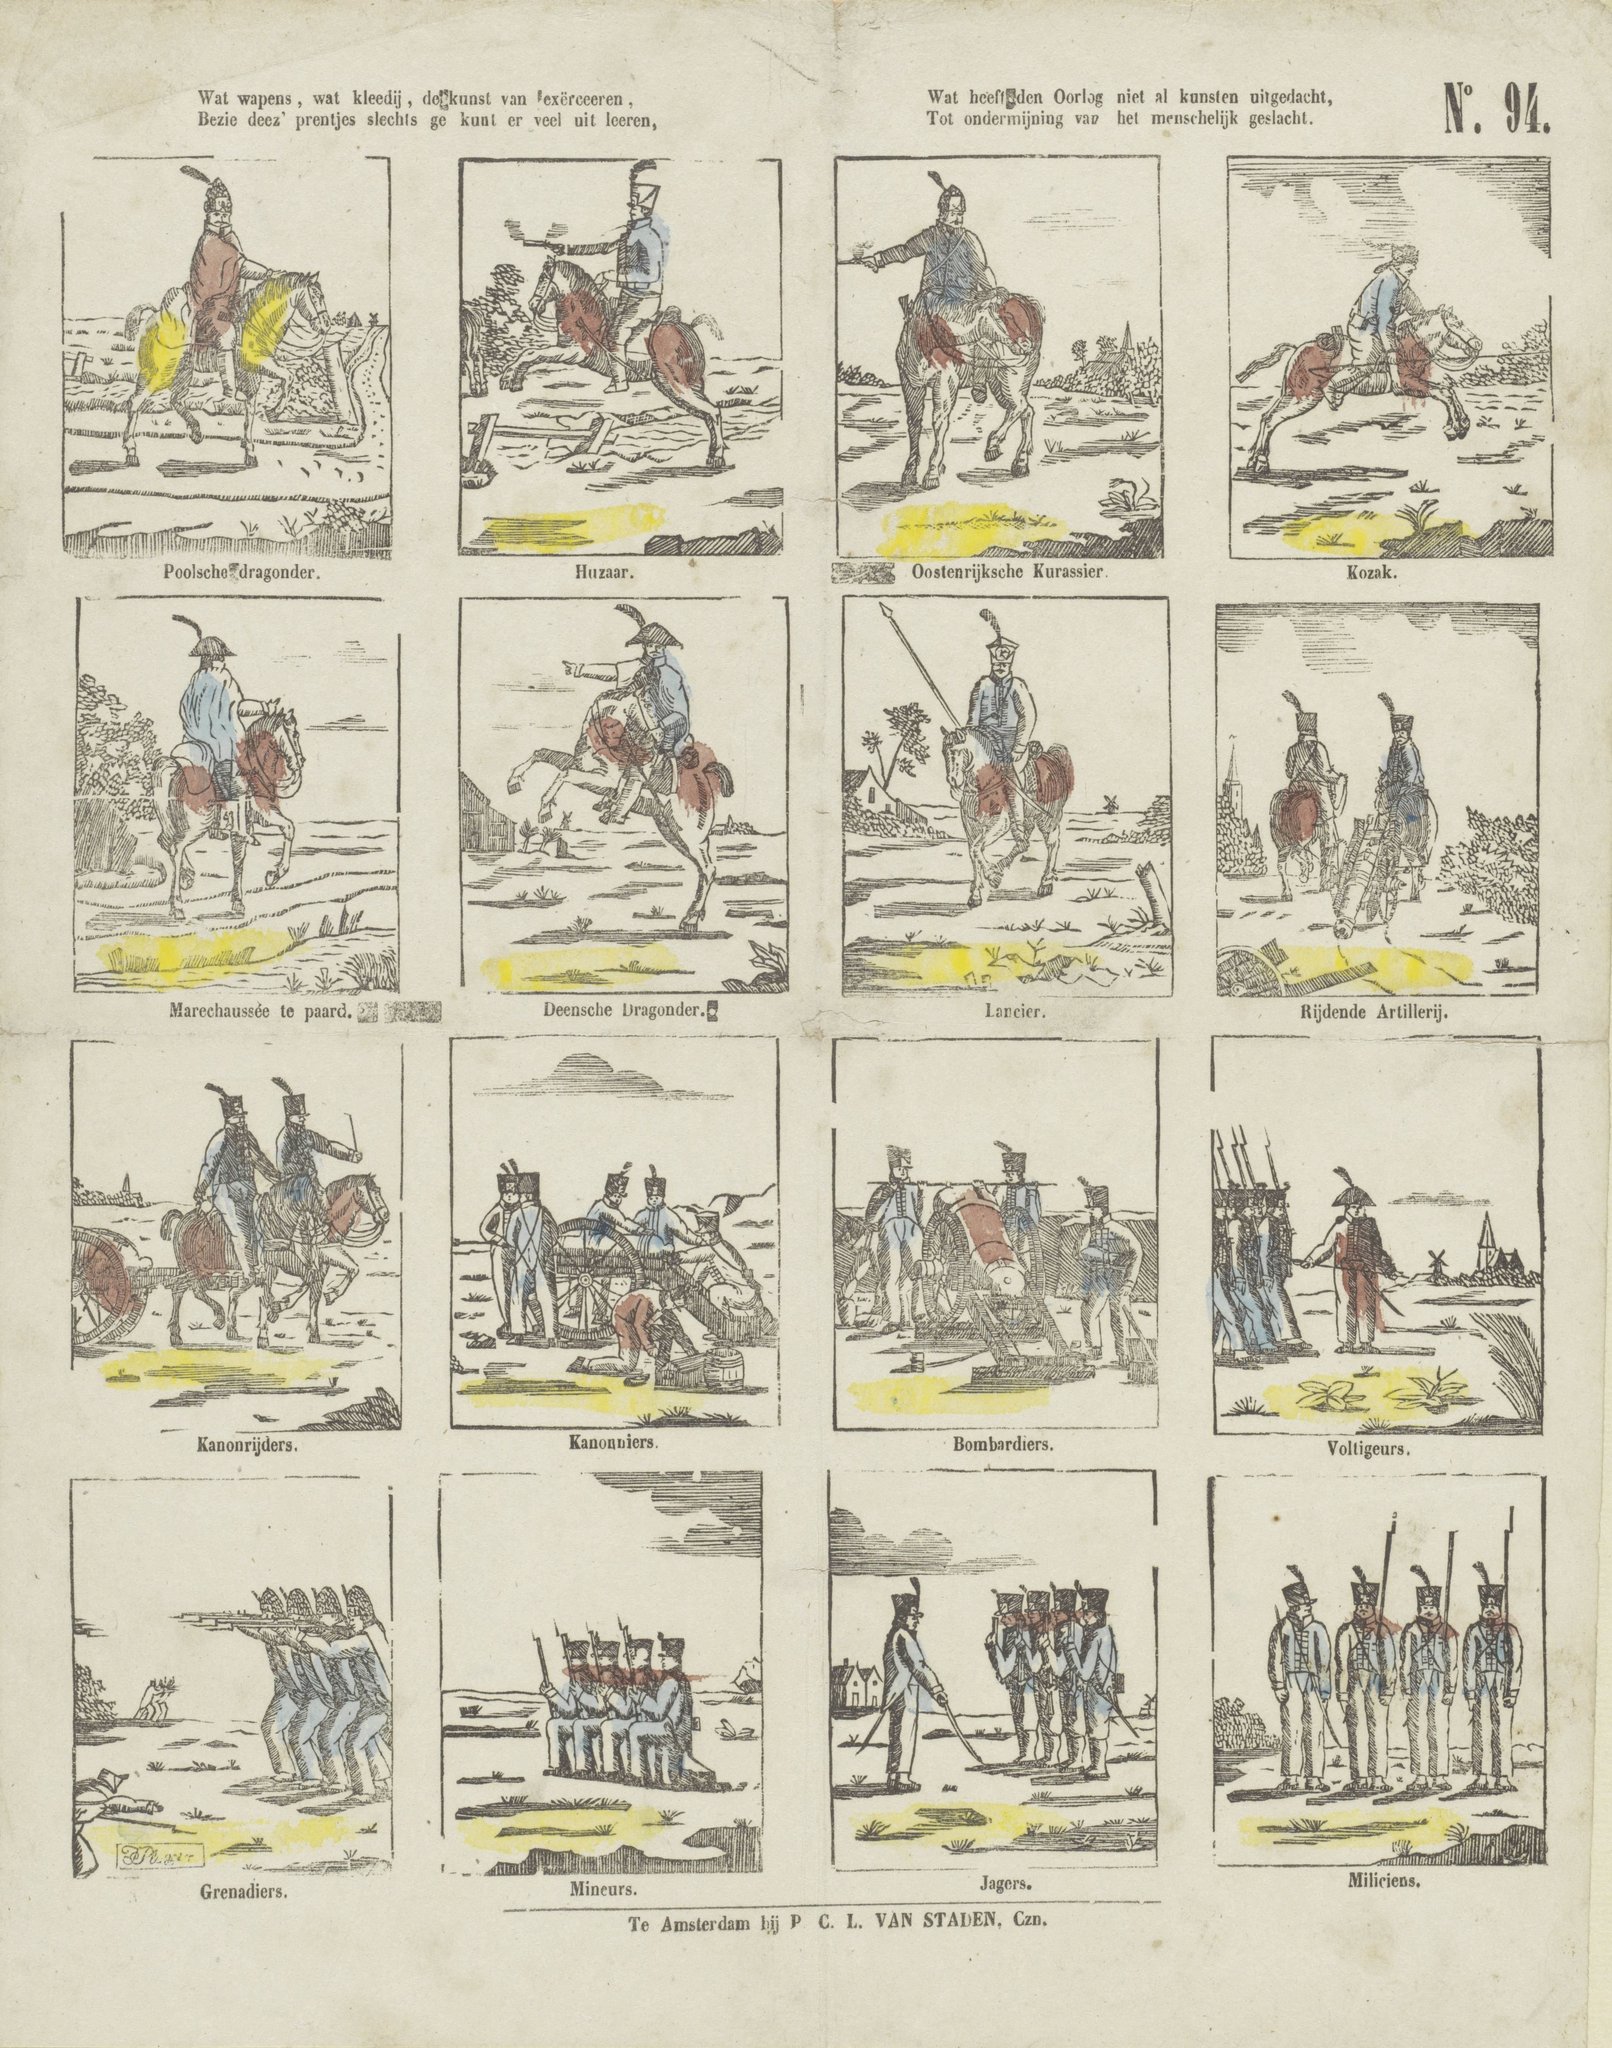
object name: print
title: Wat wapens, wat kleedij, de kunst van exërceeren, / Bezie deez' prentjes slechts ge kunt er veel uit leeren, / Wat heeft den oorlog niet al kunsten uitgedacht, / Tot ondermijning van het menschelijk geslacht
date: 1850-1870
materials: paper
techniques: colour, letterpress printing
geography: amsterdam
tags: artillery range, firing range, shooting range ~ military training, firearms: cannon (+ handling of weapons), warfare; military affairs (+ cavalry, horsemen), the soldier; the soldier's life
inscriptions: collector's mark: Lugt 2760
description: Blad met 16 voorstellingen van militairen. Onder elke afbeelding een onderschrift. Genummerd rechtsboven: No. 94.